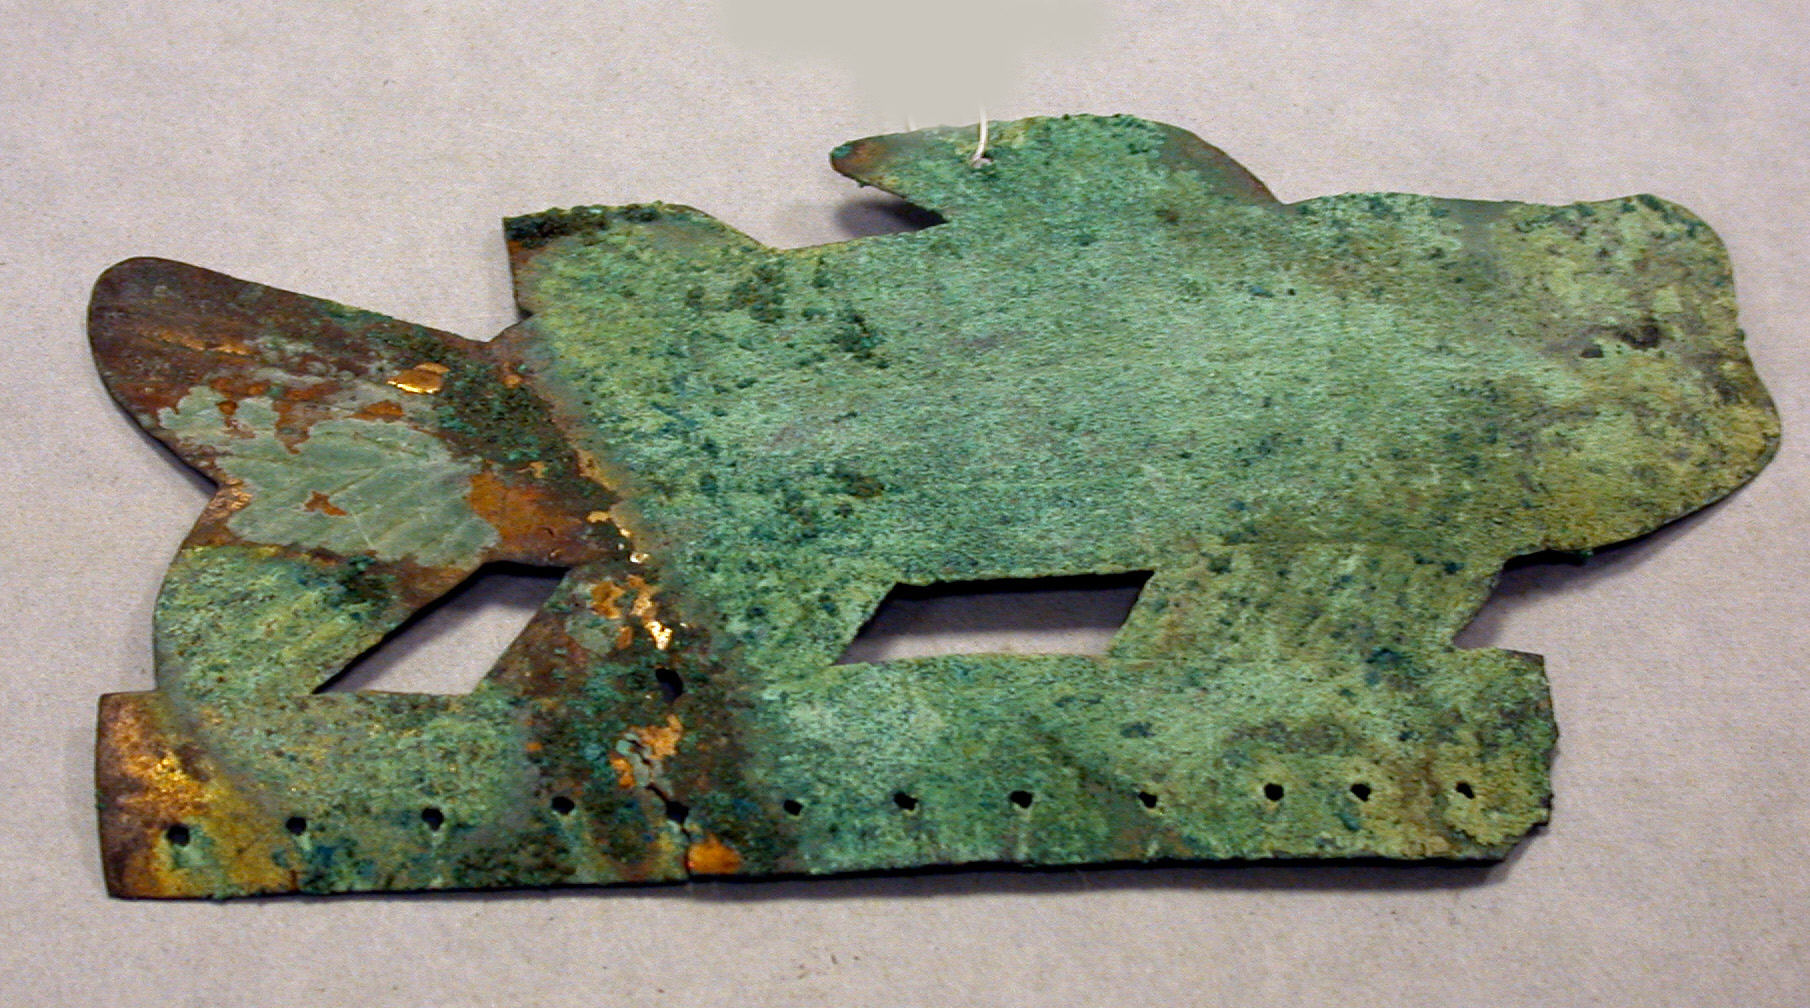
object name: ornament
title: Ornamental Fish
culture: moche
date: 100 BCE-700 CE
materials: copper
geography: peru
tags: fish